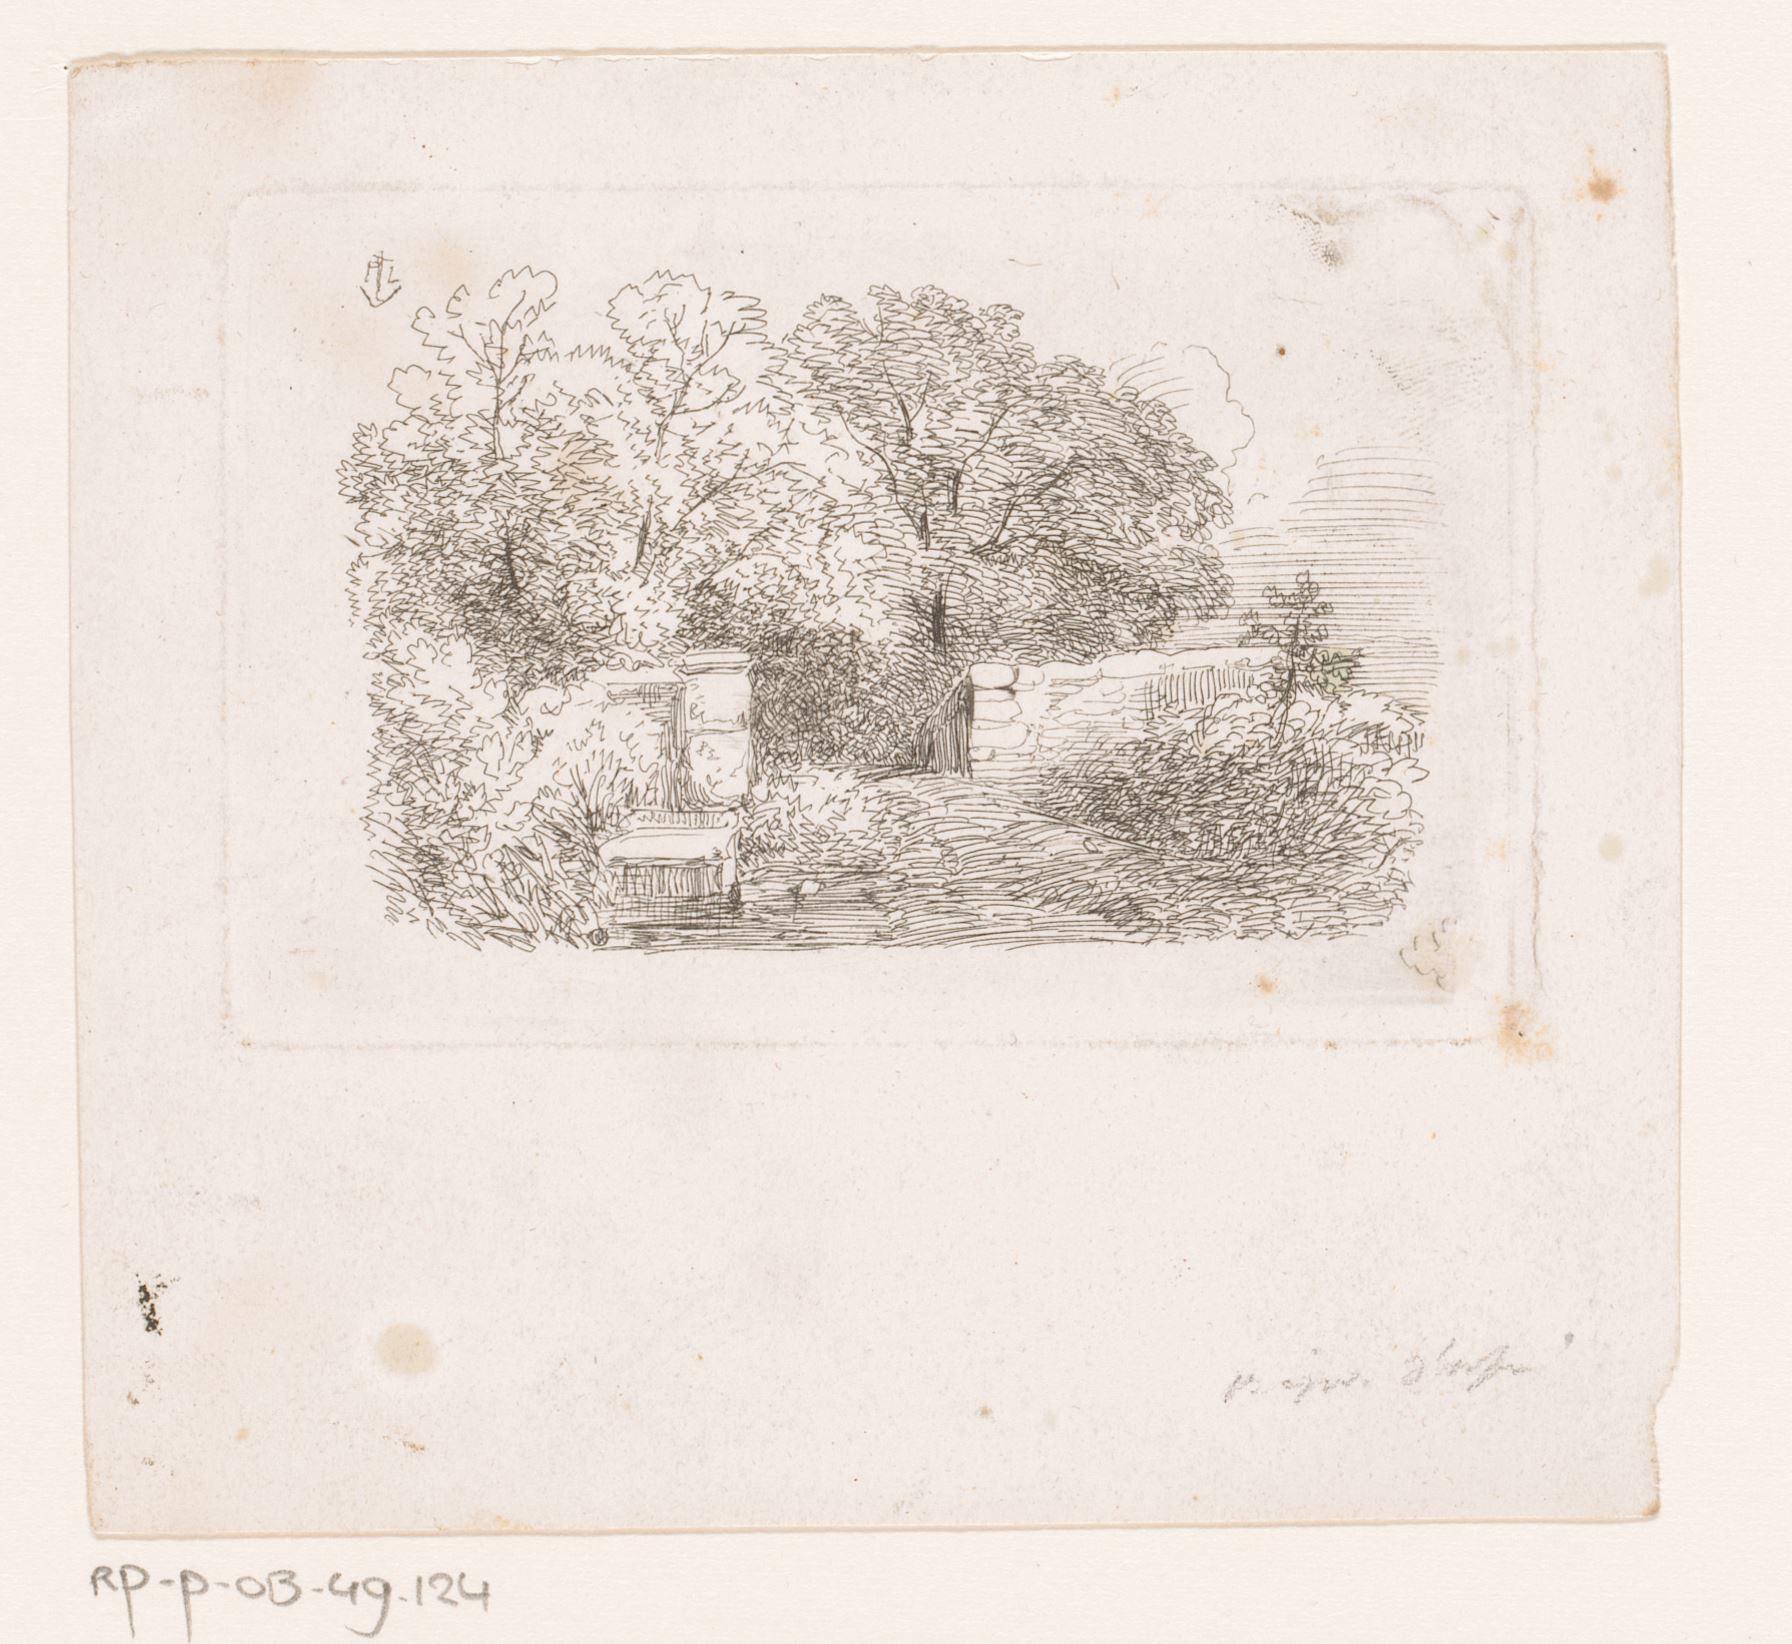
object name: print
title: Lage stenen muur met een pad door het midden naar een boompartij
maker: paulus lauters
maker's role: print maker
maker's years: 1806-1875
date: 1816-1875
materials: paper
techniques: etching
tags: forest path or lane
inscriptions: collector's mark: Lugt 2228, annotation: ‘1e épr. d'état’